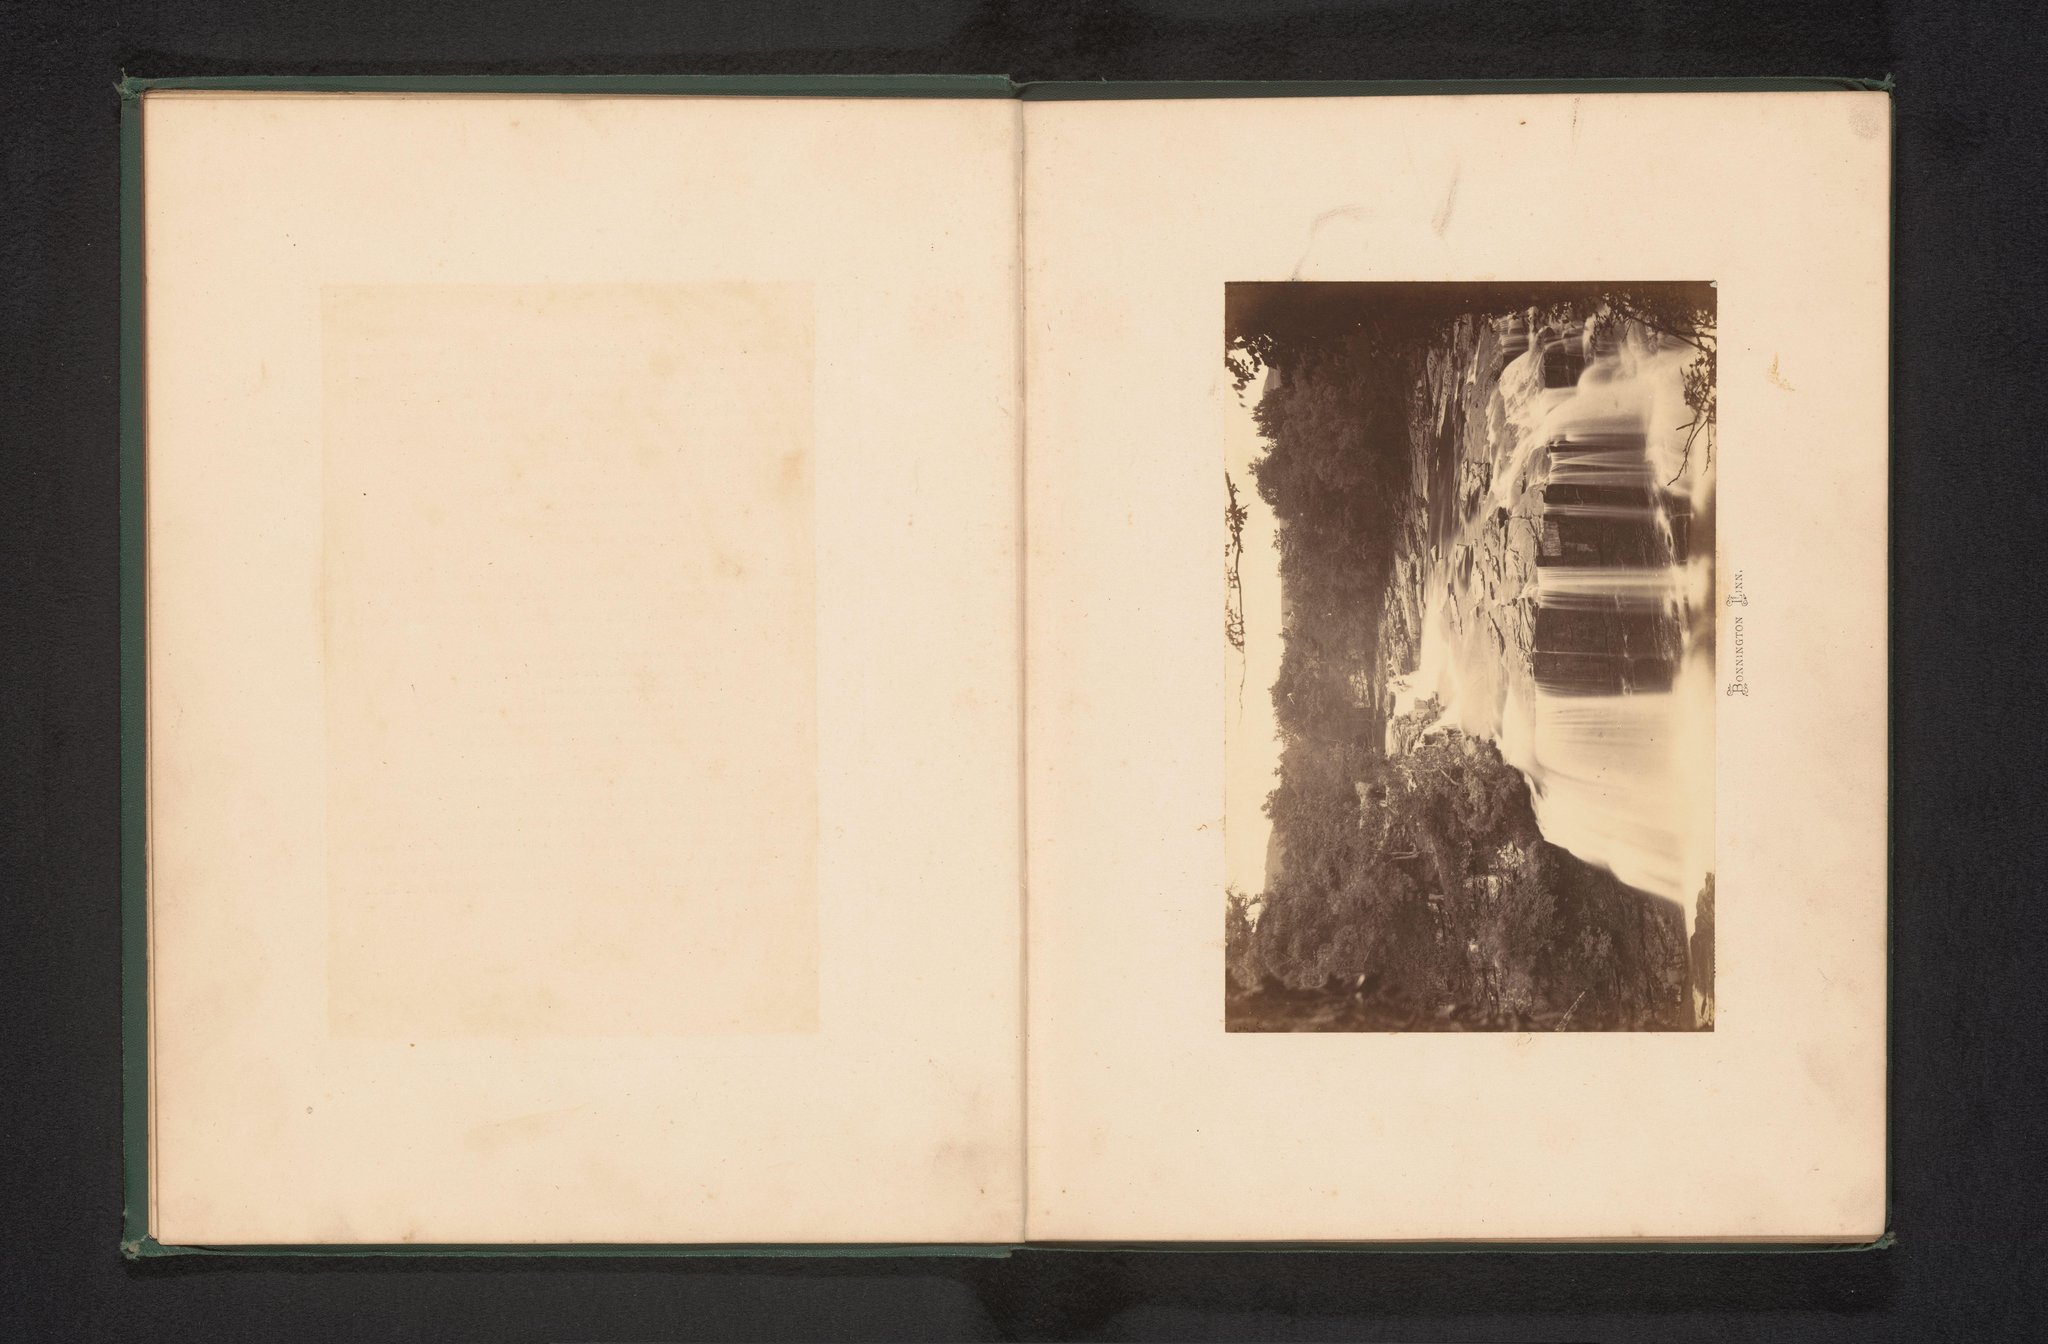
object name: photograph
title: Bonnington Linn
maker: Anonymous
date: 1862-1867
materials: photographic support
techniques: albumen print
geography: south lanarkshire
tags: waterfall, landscapes with waters, waterscapes, seascapes (in the temperate zone)